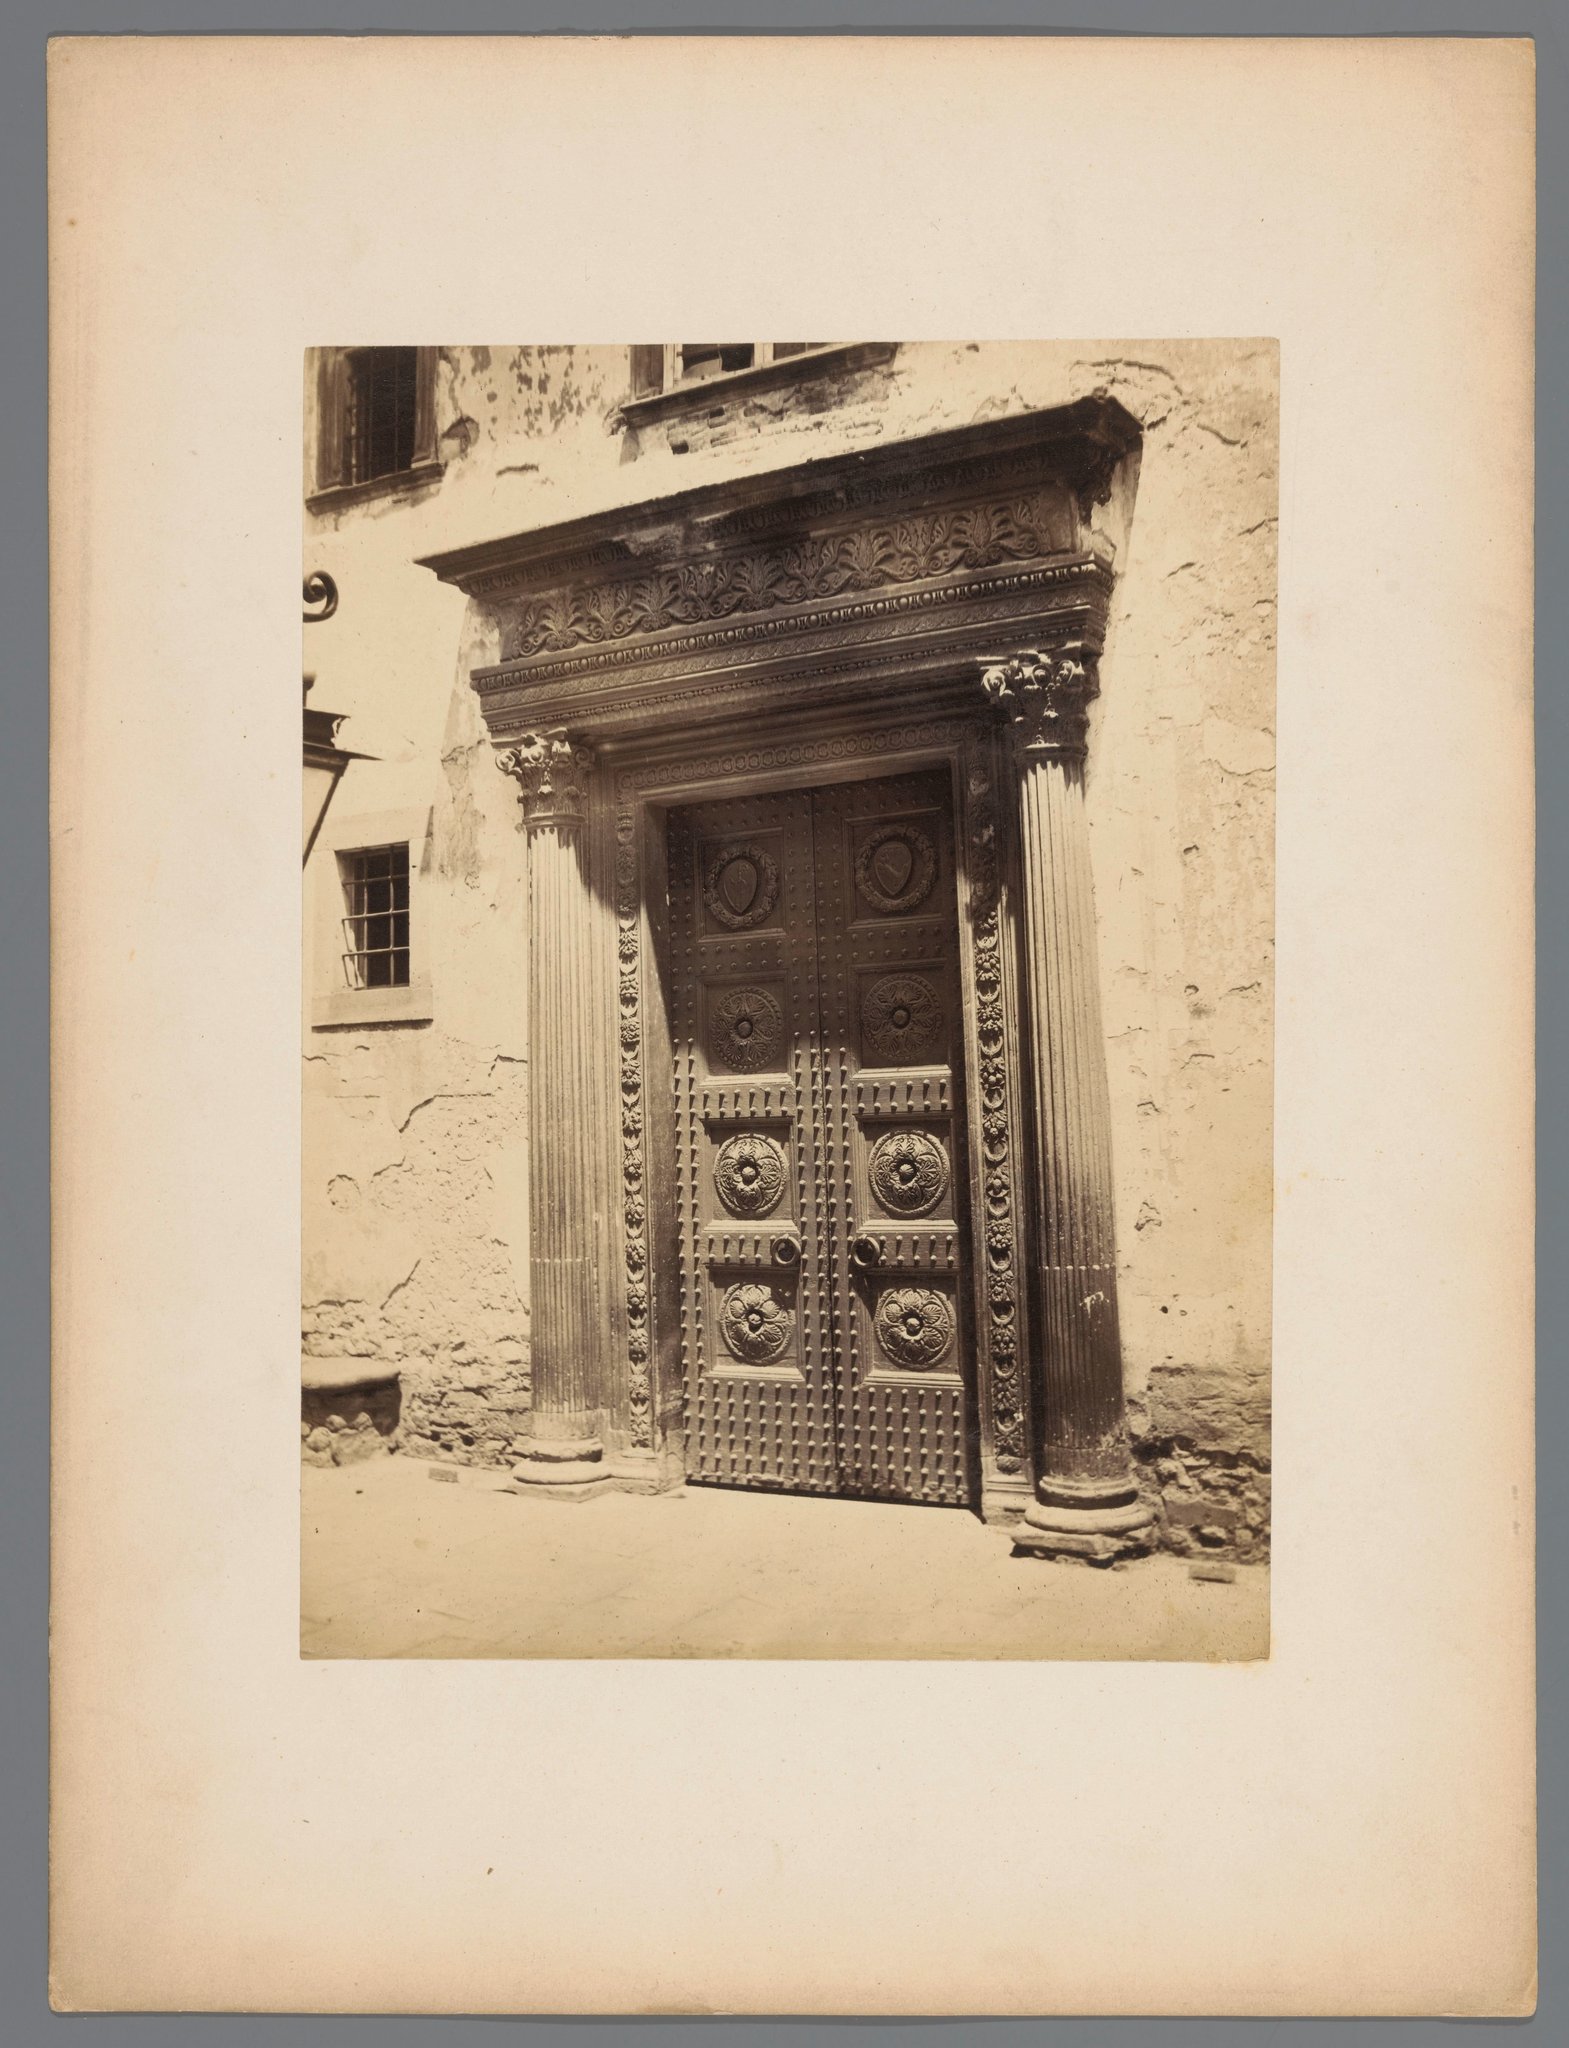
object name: photograph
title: Façade van een gebouw, vermoedelijk in Zuid-Europa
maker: Anonymous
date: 1875-1900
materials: cardboard, photographic support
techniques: albumen print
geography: southern europe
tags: façade (of house or building), closed door, flowers ~ ornament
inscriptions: collector's mark: Lugt 3937